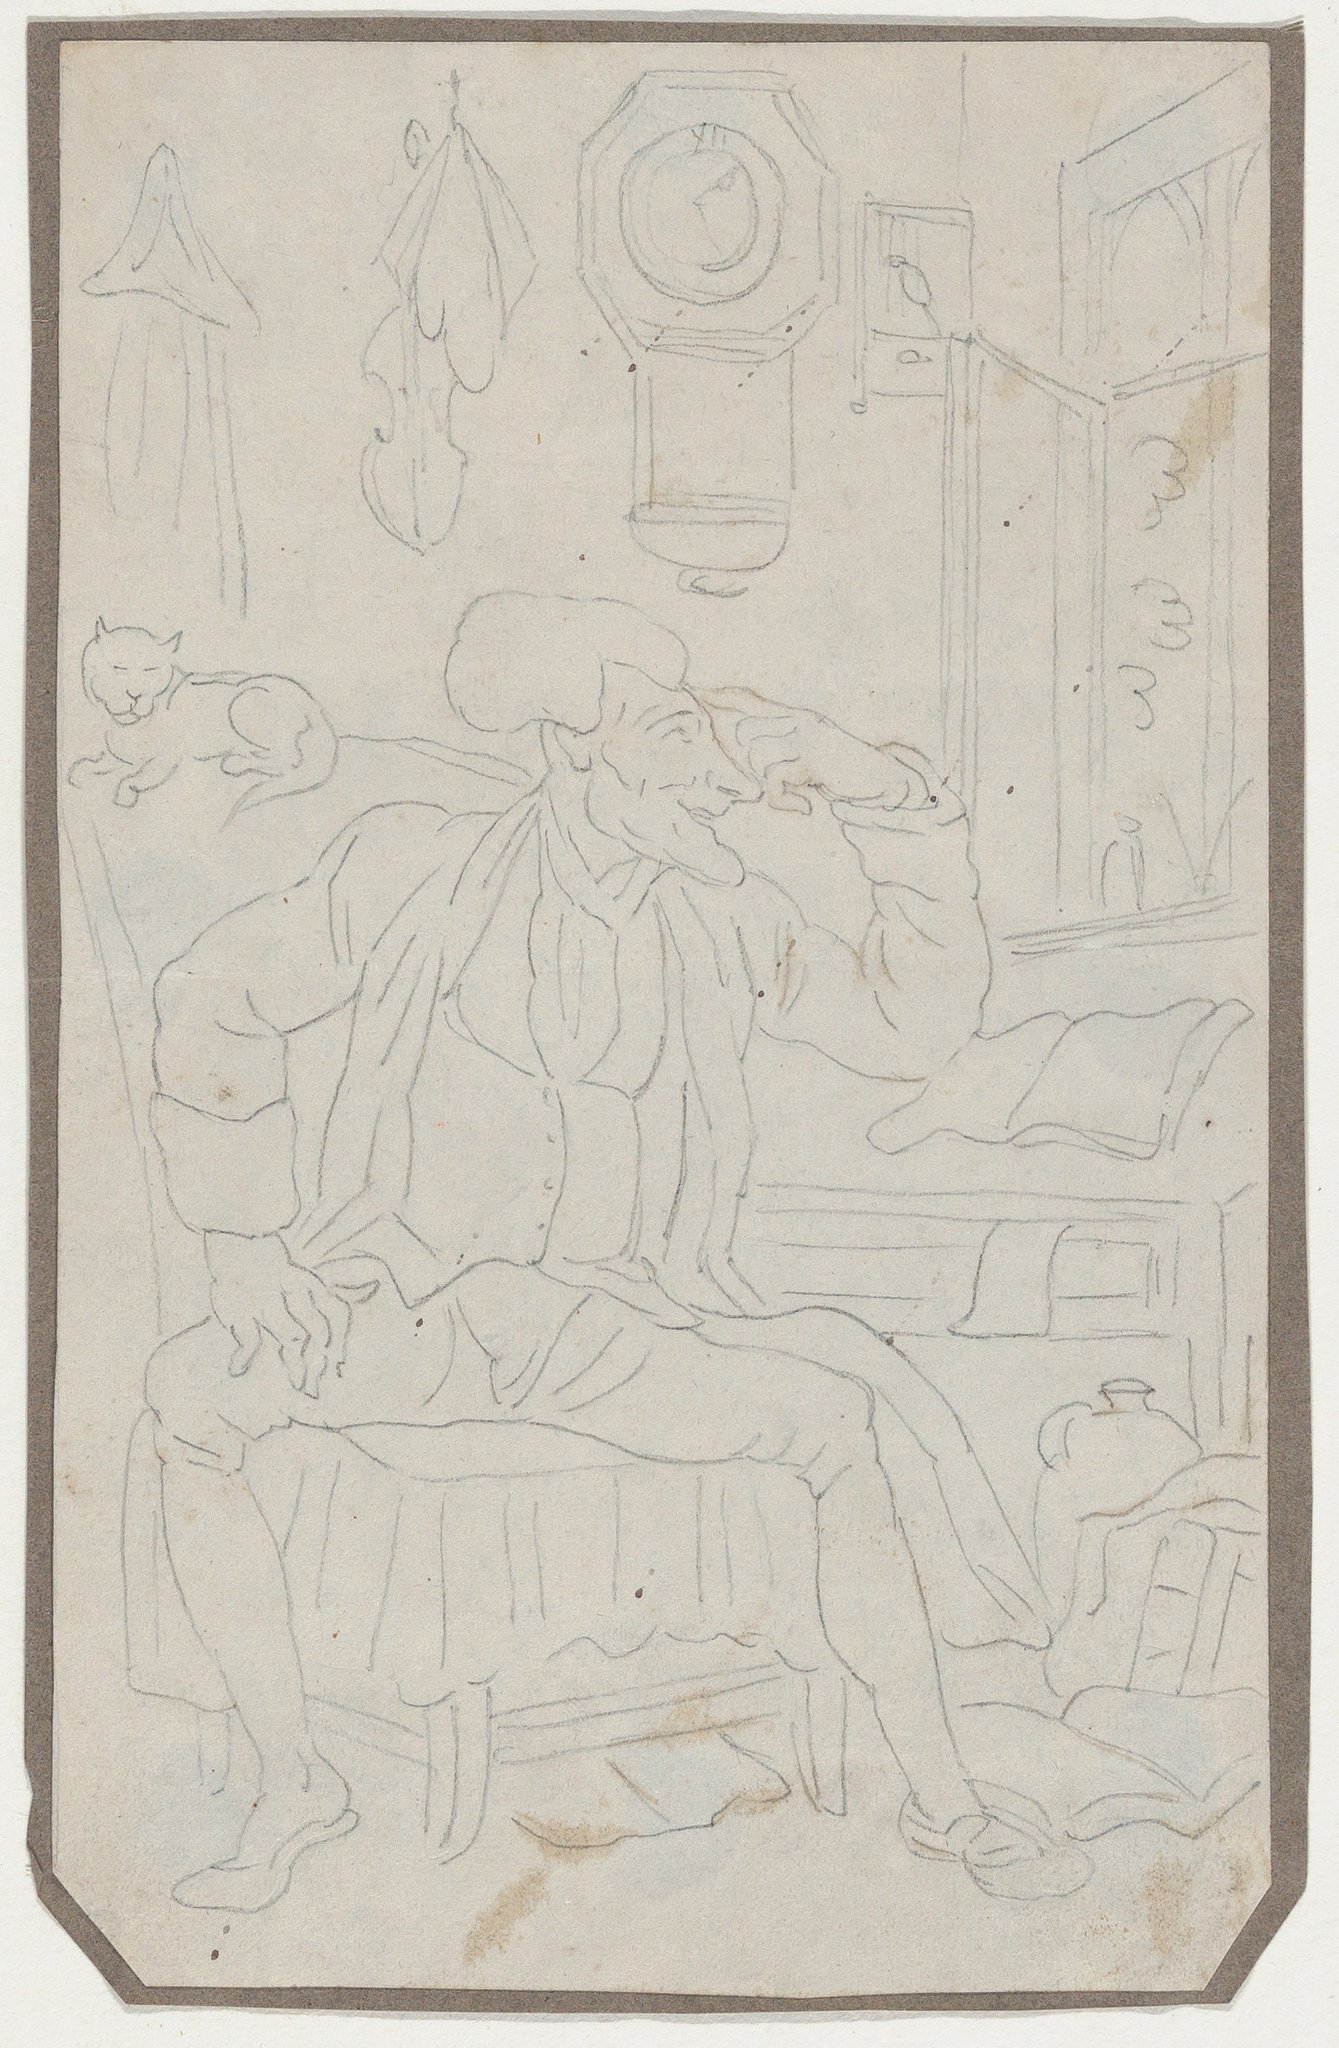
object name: drawing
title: Tracing of scene from Dr. Syntax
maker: thomas rowlandson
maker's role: artist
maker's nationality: british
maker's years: 1757-1827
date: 1819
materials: graphite